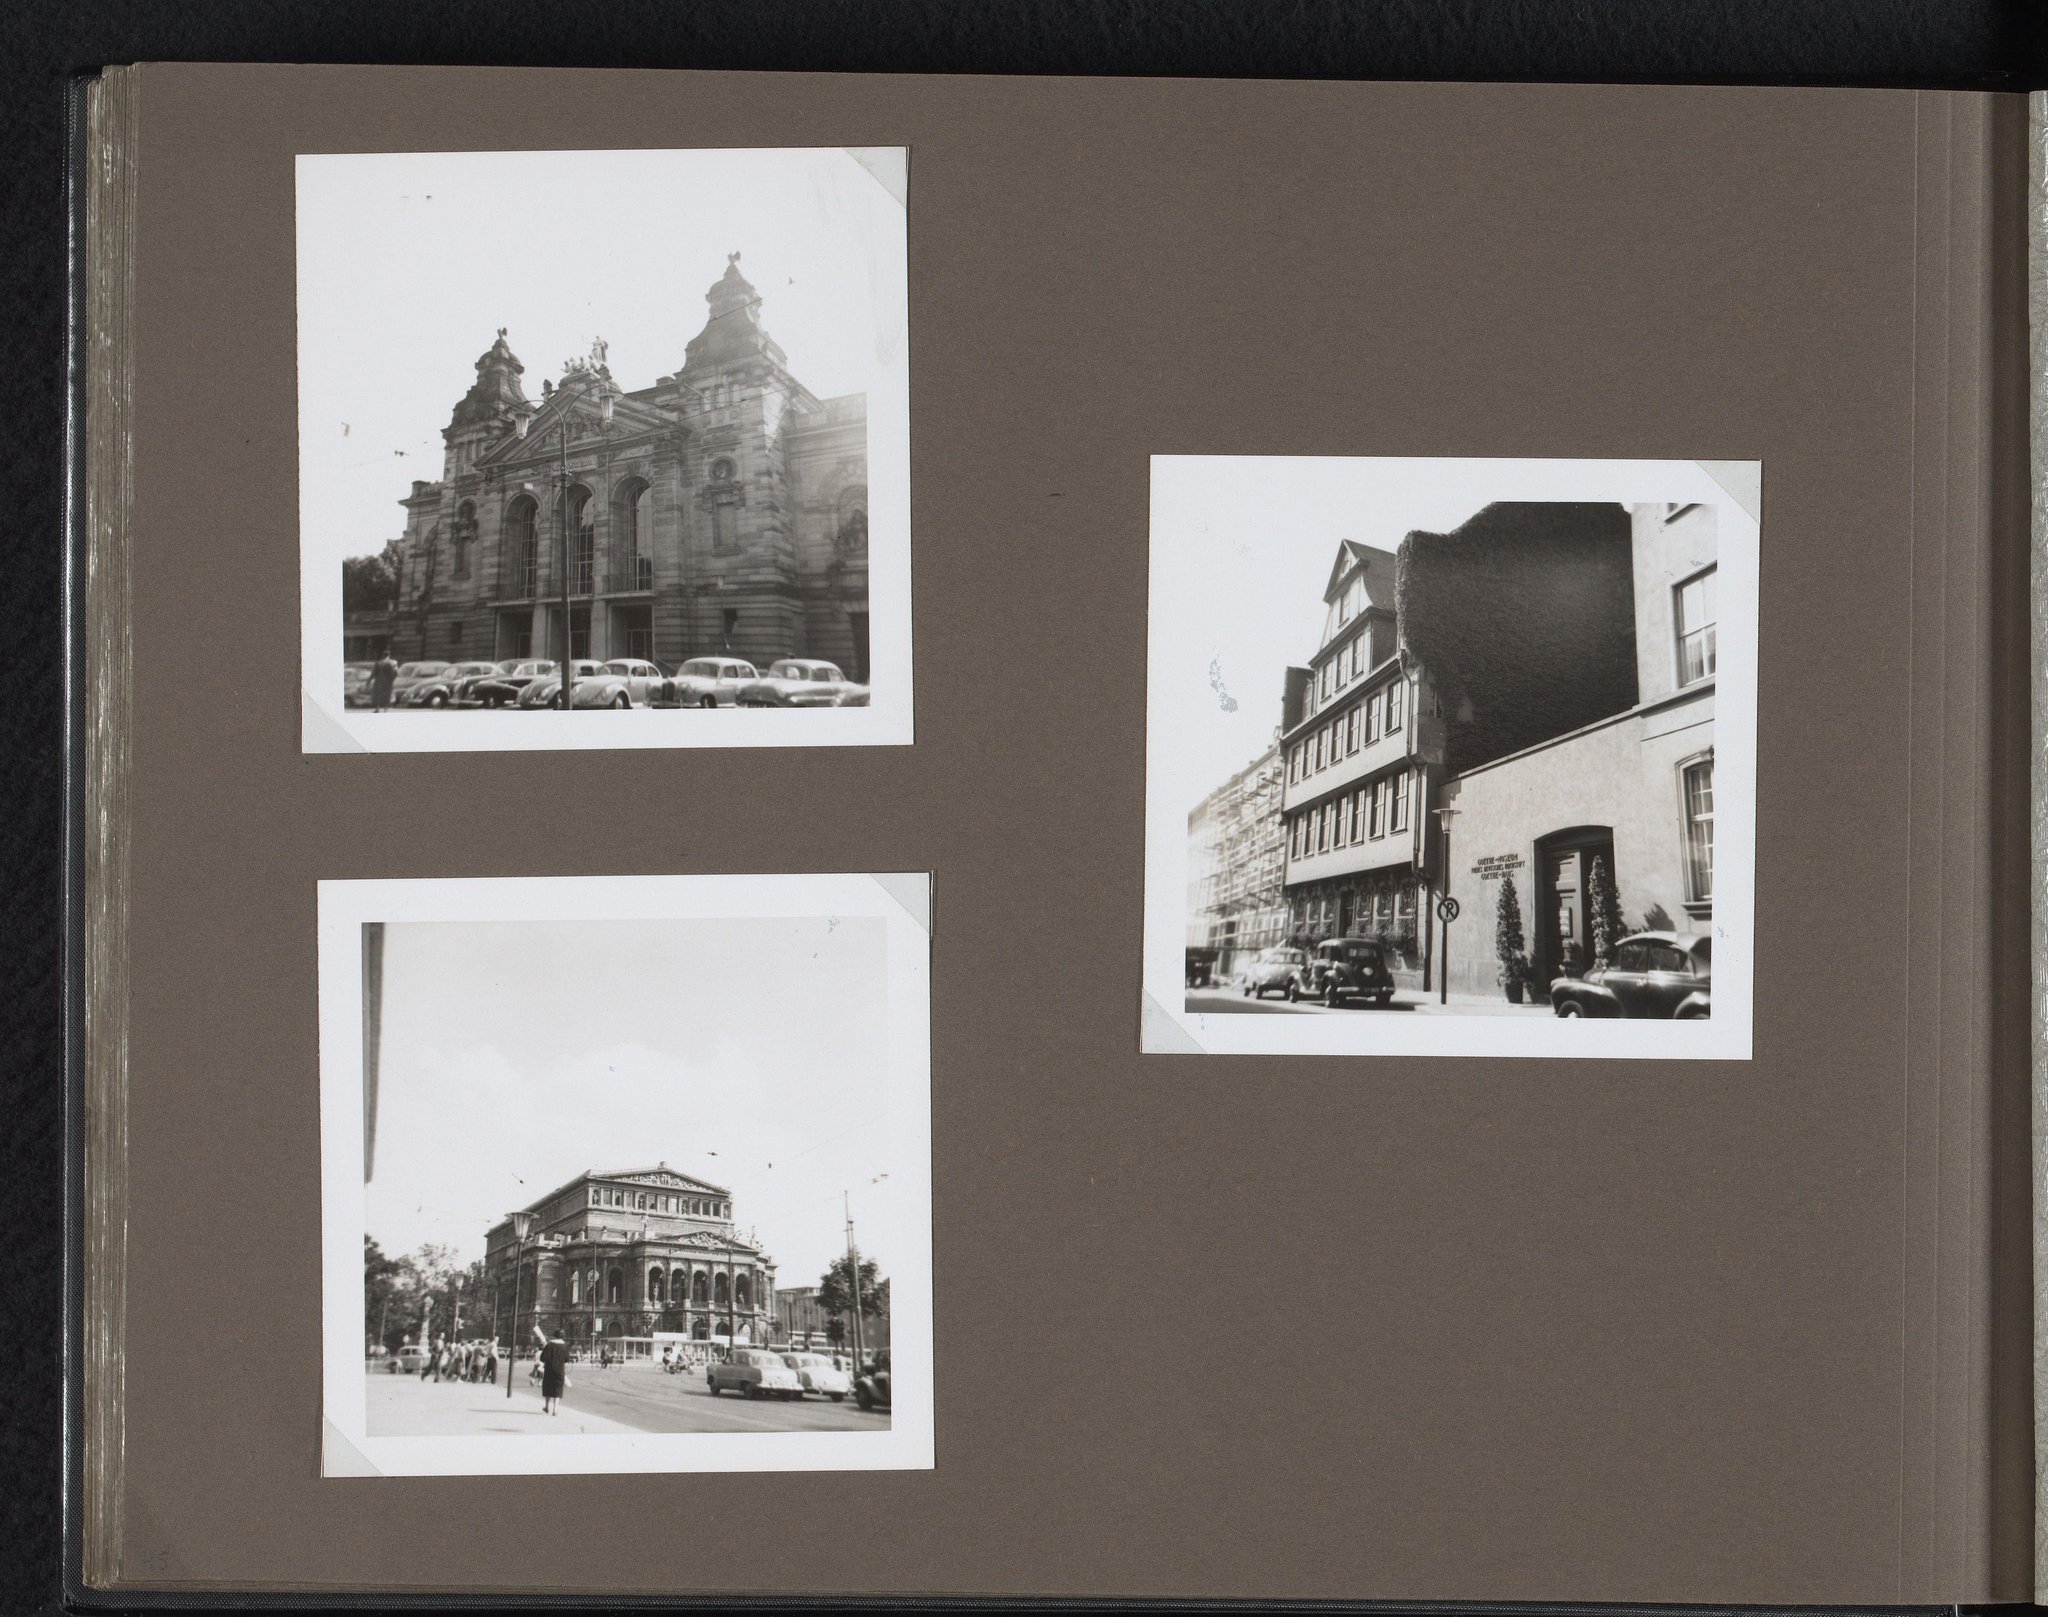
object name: album leaf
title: Straatgezichten in Wenen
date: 1955-1970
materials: paper, cardboard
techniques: gelatin silver print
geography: vienna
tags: city-view, and landscape with man-made constructions, façade (of house or building), vienna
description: Blad bevat drie foto's. Zonder personen gerelateerd aan de familie Wachenheimer. Deze foto's maken deel uit van een album.